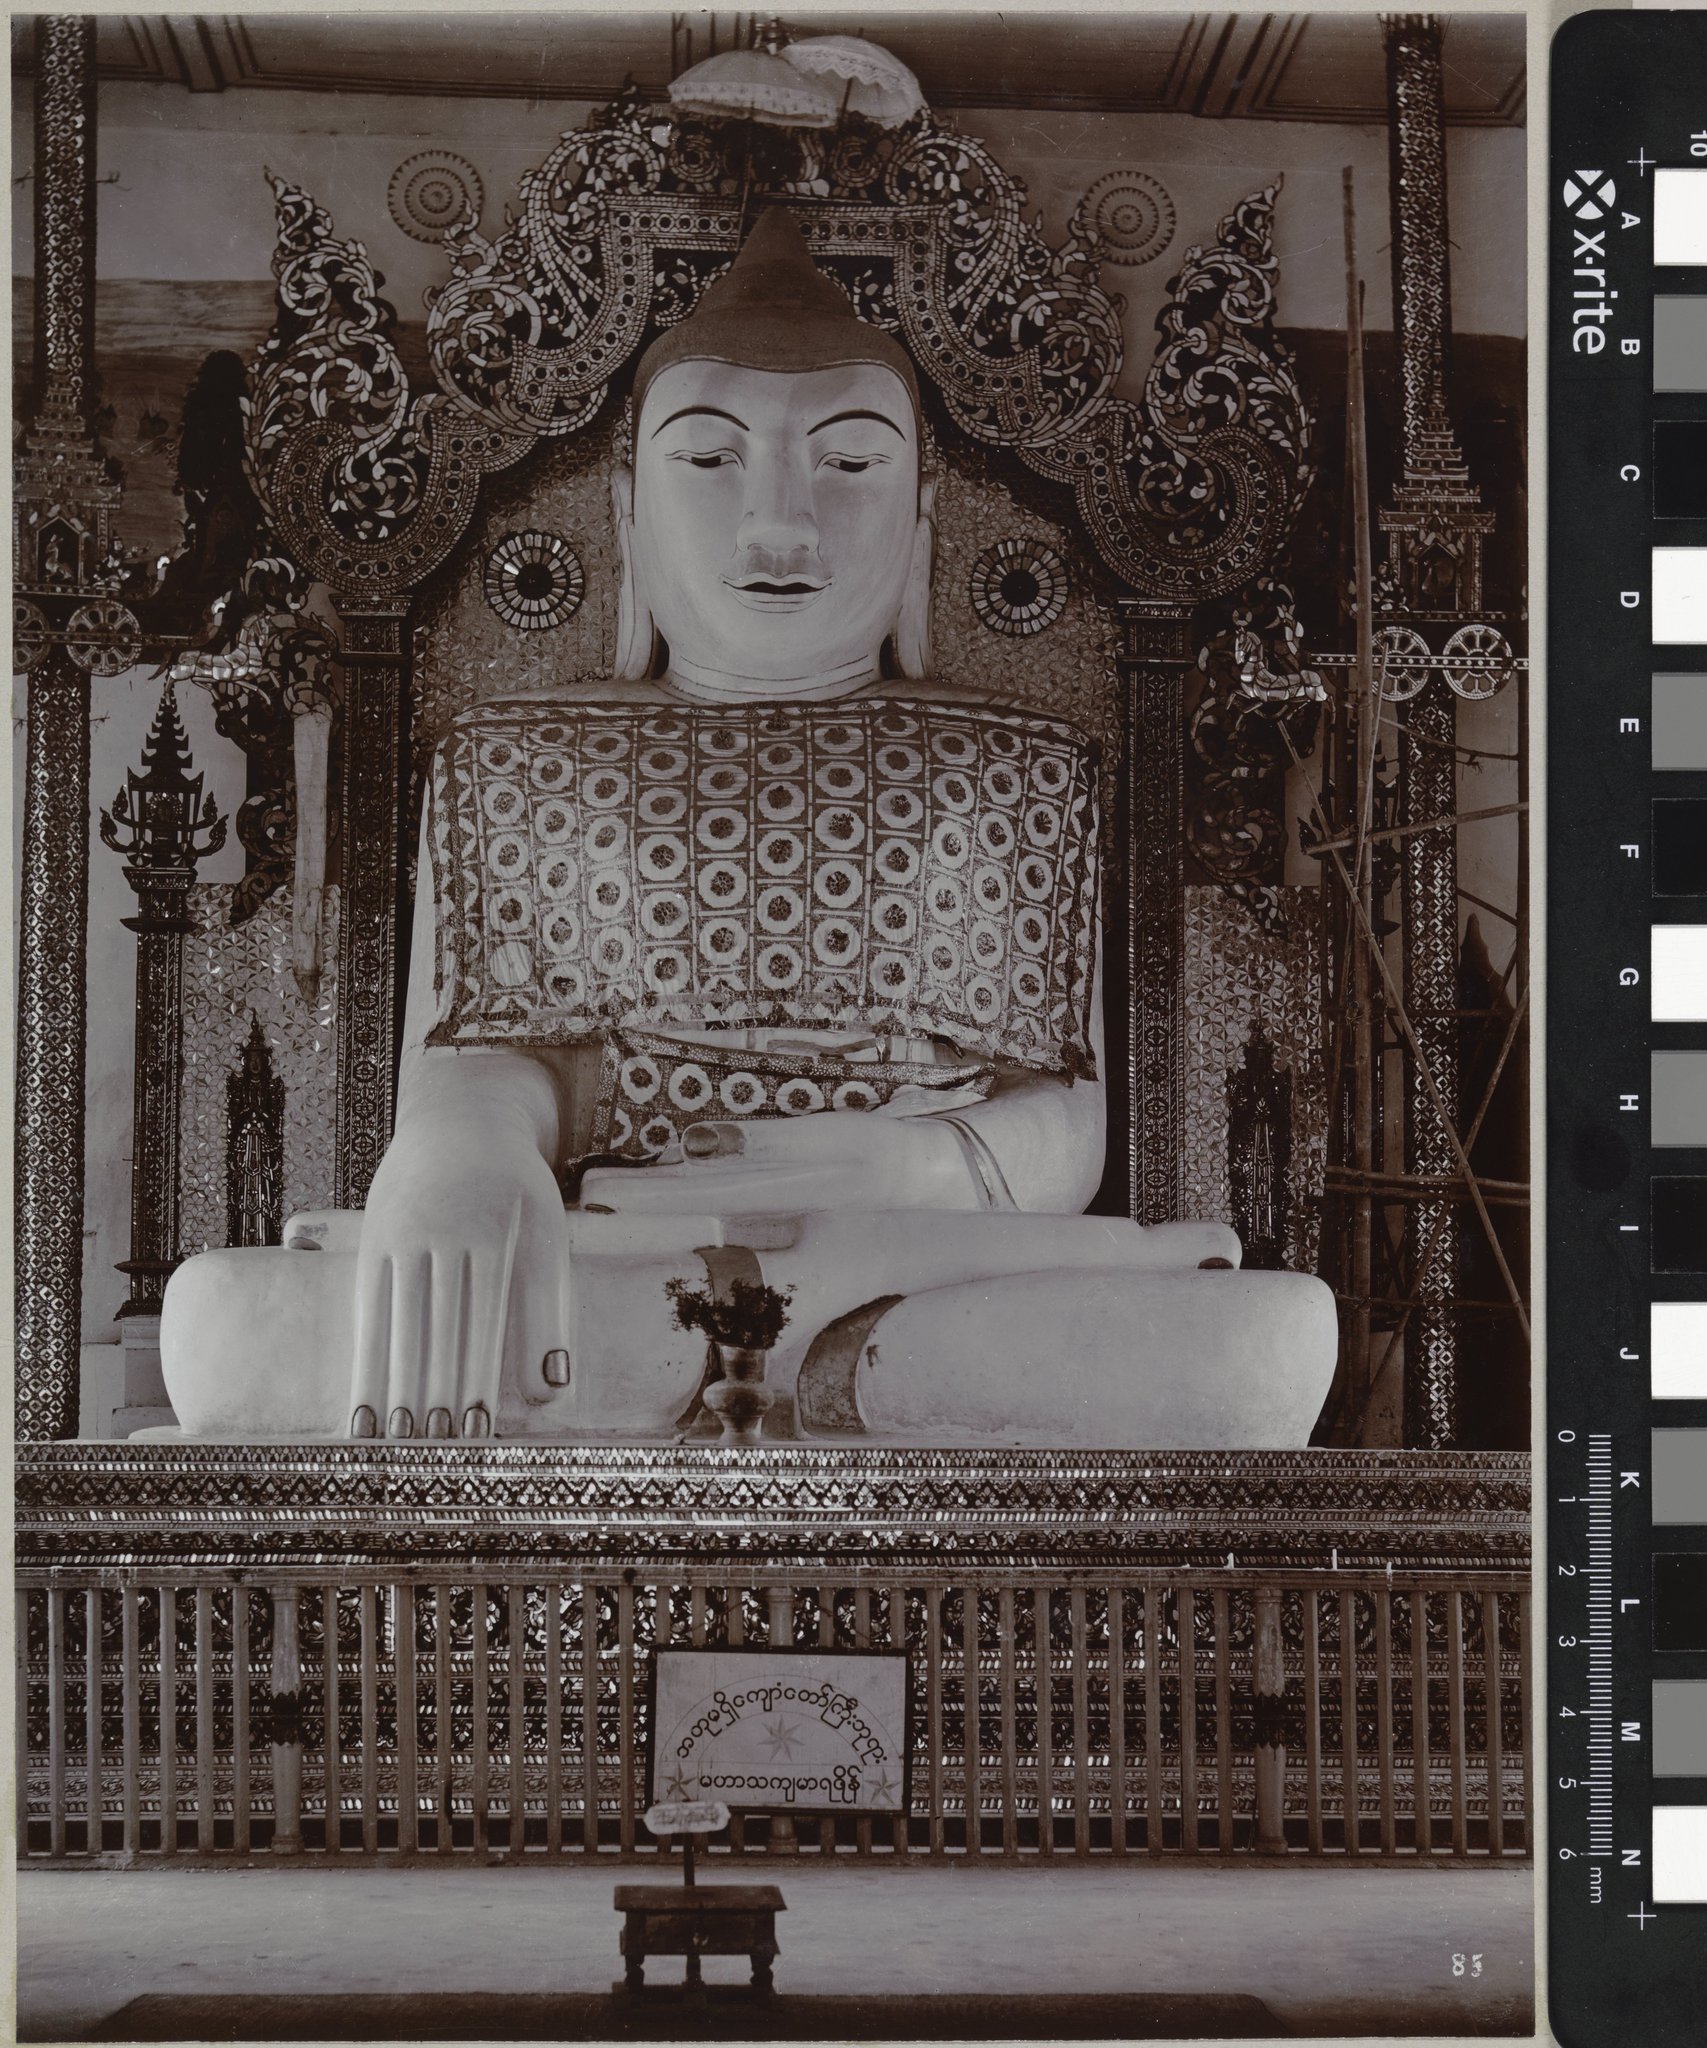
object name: photograph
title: Buddha idol in the Kyautawgyi temple, Mandalay, Myanmar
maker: Anonymous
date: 1895-1915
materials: paper, cardboard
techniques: collodion silver print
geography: mandalay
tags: temple, shrine ~ hinduism, buddhism, jainism, monument, statue, buddha, founder of buddhism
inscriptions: number: ‘85’, inscription: ‘16. Mandalay’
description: De Grote Marmeren Boeddha staat in de bekende Kyauktawgyi tempel in Mandalay, Myanmar. Het beeld zelf heet Maha Thetkya Mayazein. De rechterhand van de boeddha is in bhūmisparśa mudrā (afgeleid van het Sanskriet bhūmi, Moeder Aarde, en sparśa, aanraking) en de linkerhand in dhyāna mudrā. Veel Boeddhabeelden in Myanmar hebben deze houding. Deze foto maakt deel uit van een album.